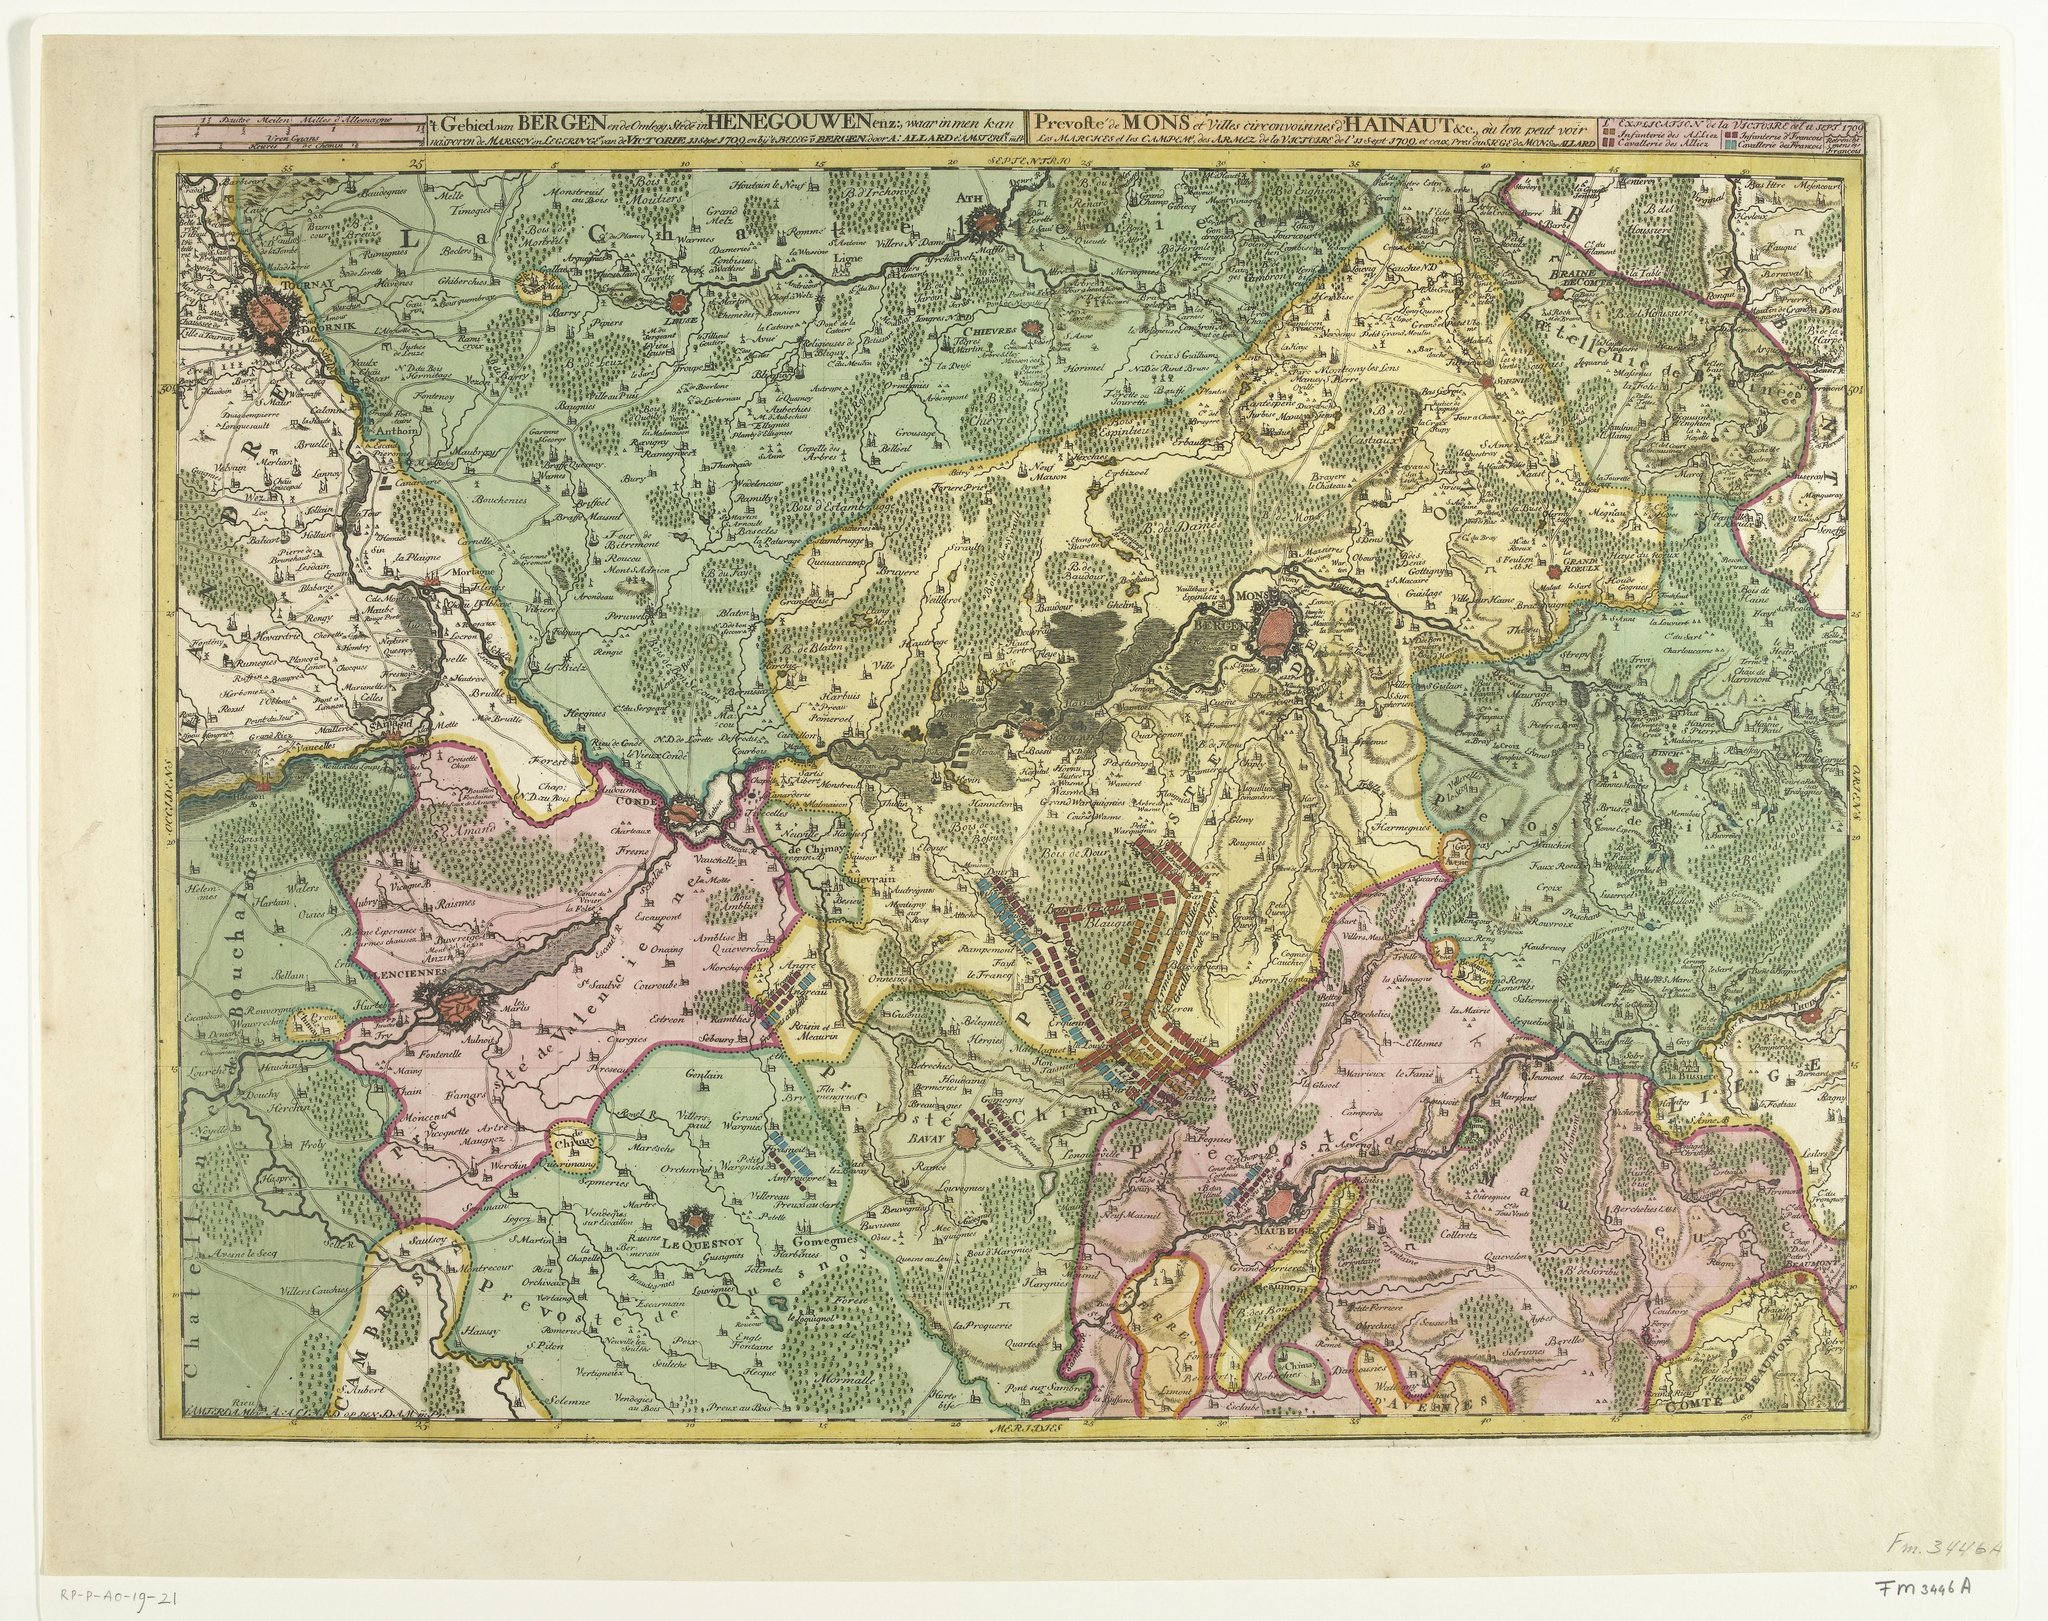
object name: map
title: Kaart van Hengouwen met Bergen en omliggende steden, 1709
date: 1709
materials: paper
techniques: etching, hand coloring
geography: amsterdam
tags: maps of separate countries or regions, henegouwen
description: Kaart van Hengouwen met Mons (Bergen) en omliggende steden (Valenciennes, Condé, Tournai, Ath en Maubeuge), met de posities van de legers bij de slag bij Malplaquet op 11 september 1709.